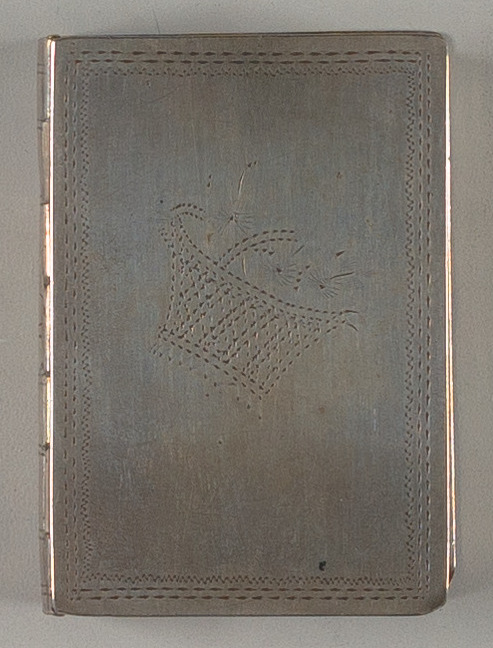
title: Vinaigrette box, M. or A. Ebsen, 1845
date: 1845